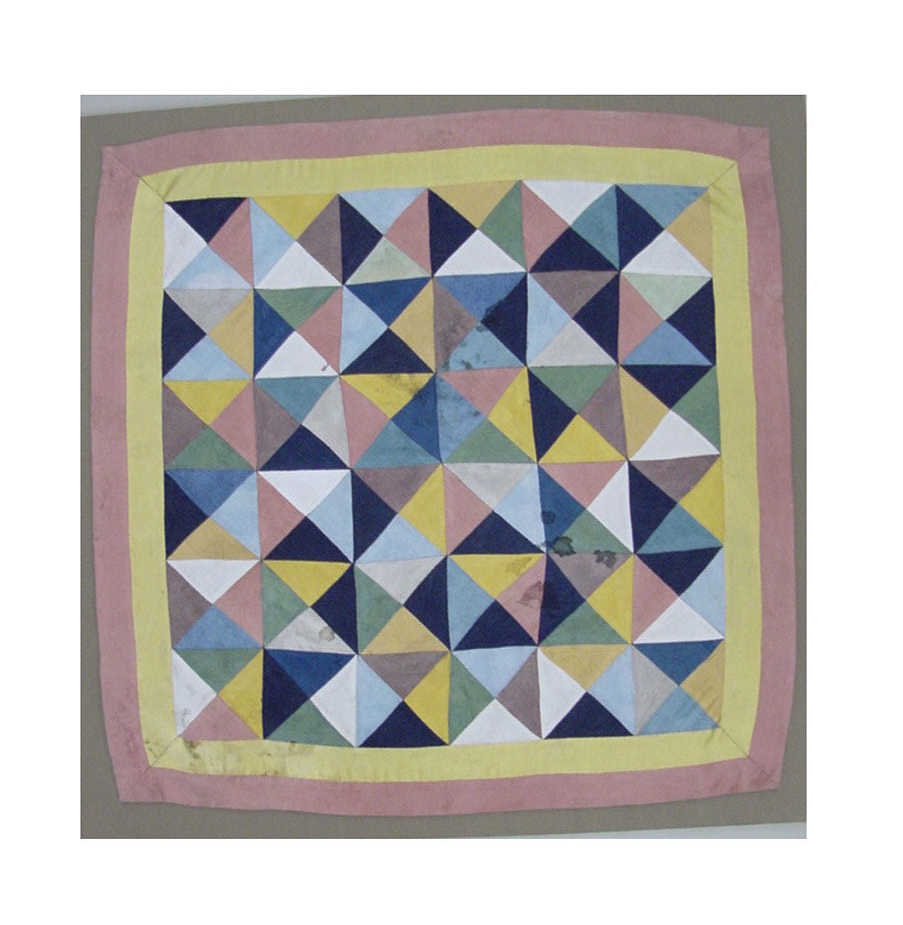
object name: patchwork of woven textile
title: Patchwork of woven textiles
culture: chinese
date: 1601-1800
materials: silk